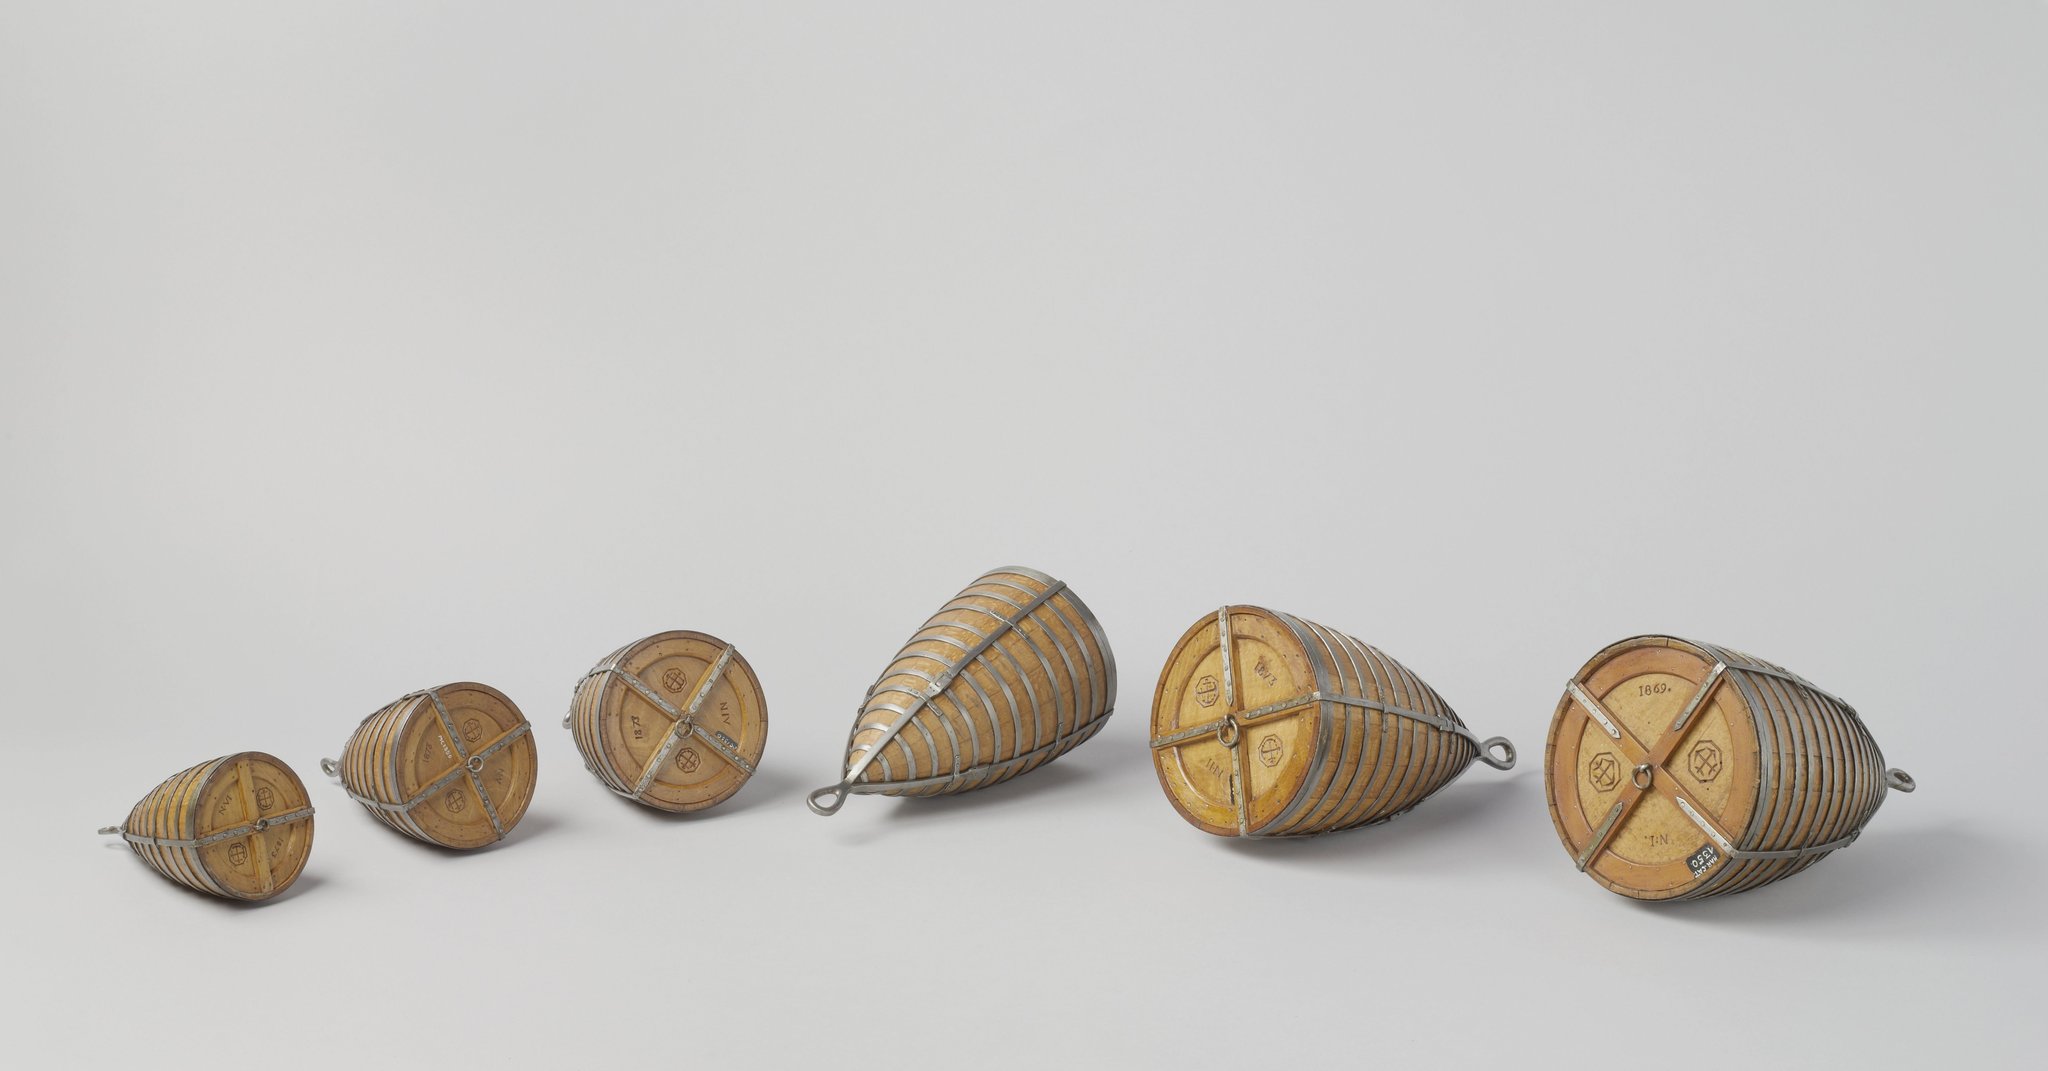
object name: demonstration model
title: Model of a Buoy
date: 1869-1873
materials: iron, wood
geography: enkhuizen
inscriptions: inscription: ‘NIV / 1873’, monogram: crossed anchors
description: Model van een boei (buikton) met een conisch lichaam met een scherp uiteinde en een ronde platte bovenkant met een ring in het midden. Zoals een vat is zij samengesteld uit duigen en hoepels. Onderaan zit een oog voor de ankerketting. Gemerkt met gekruiste ankers. Model behoort bij serie van zes boeien van verschillende formaten. Schaal 1:10 (archief).